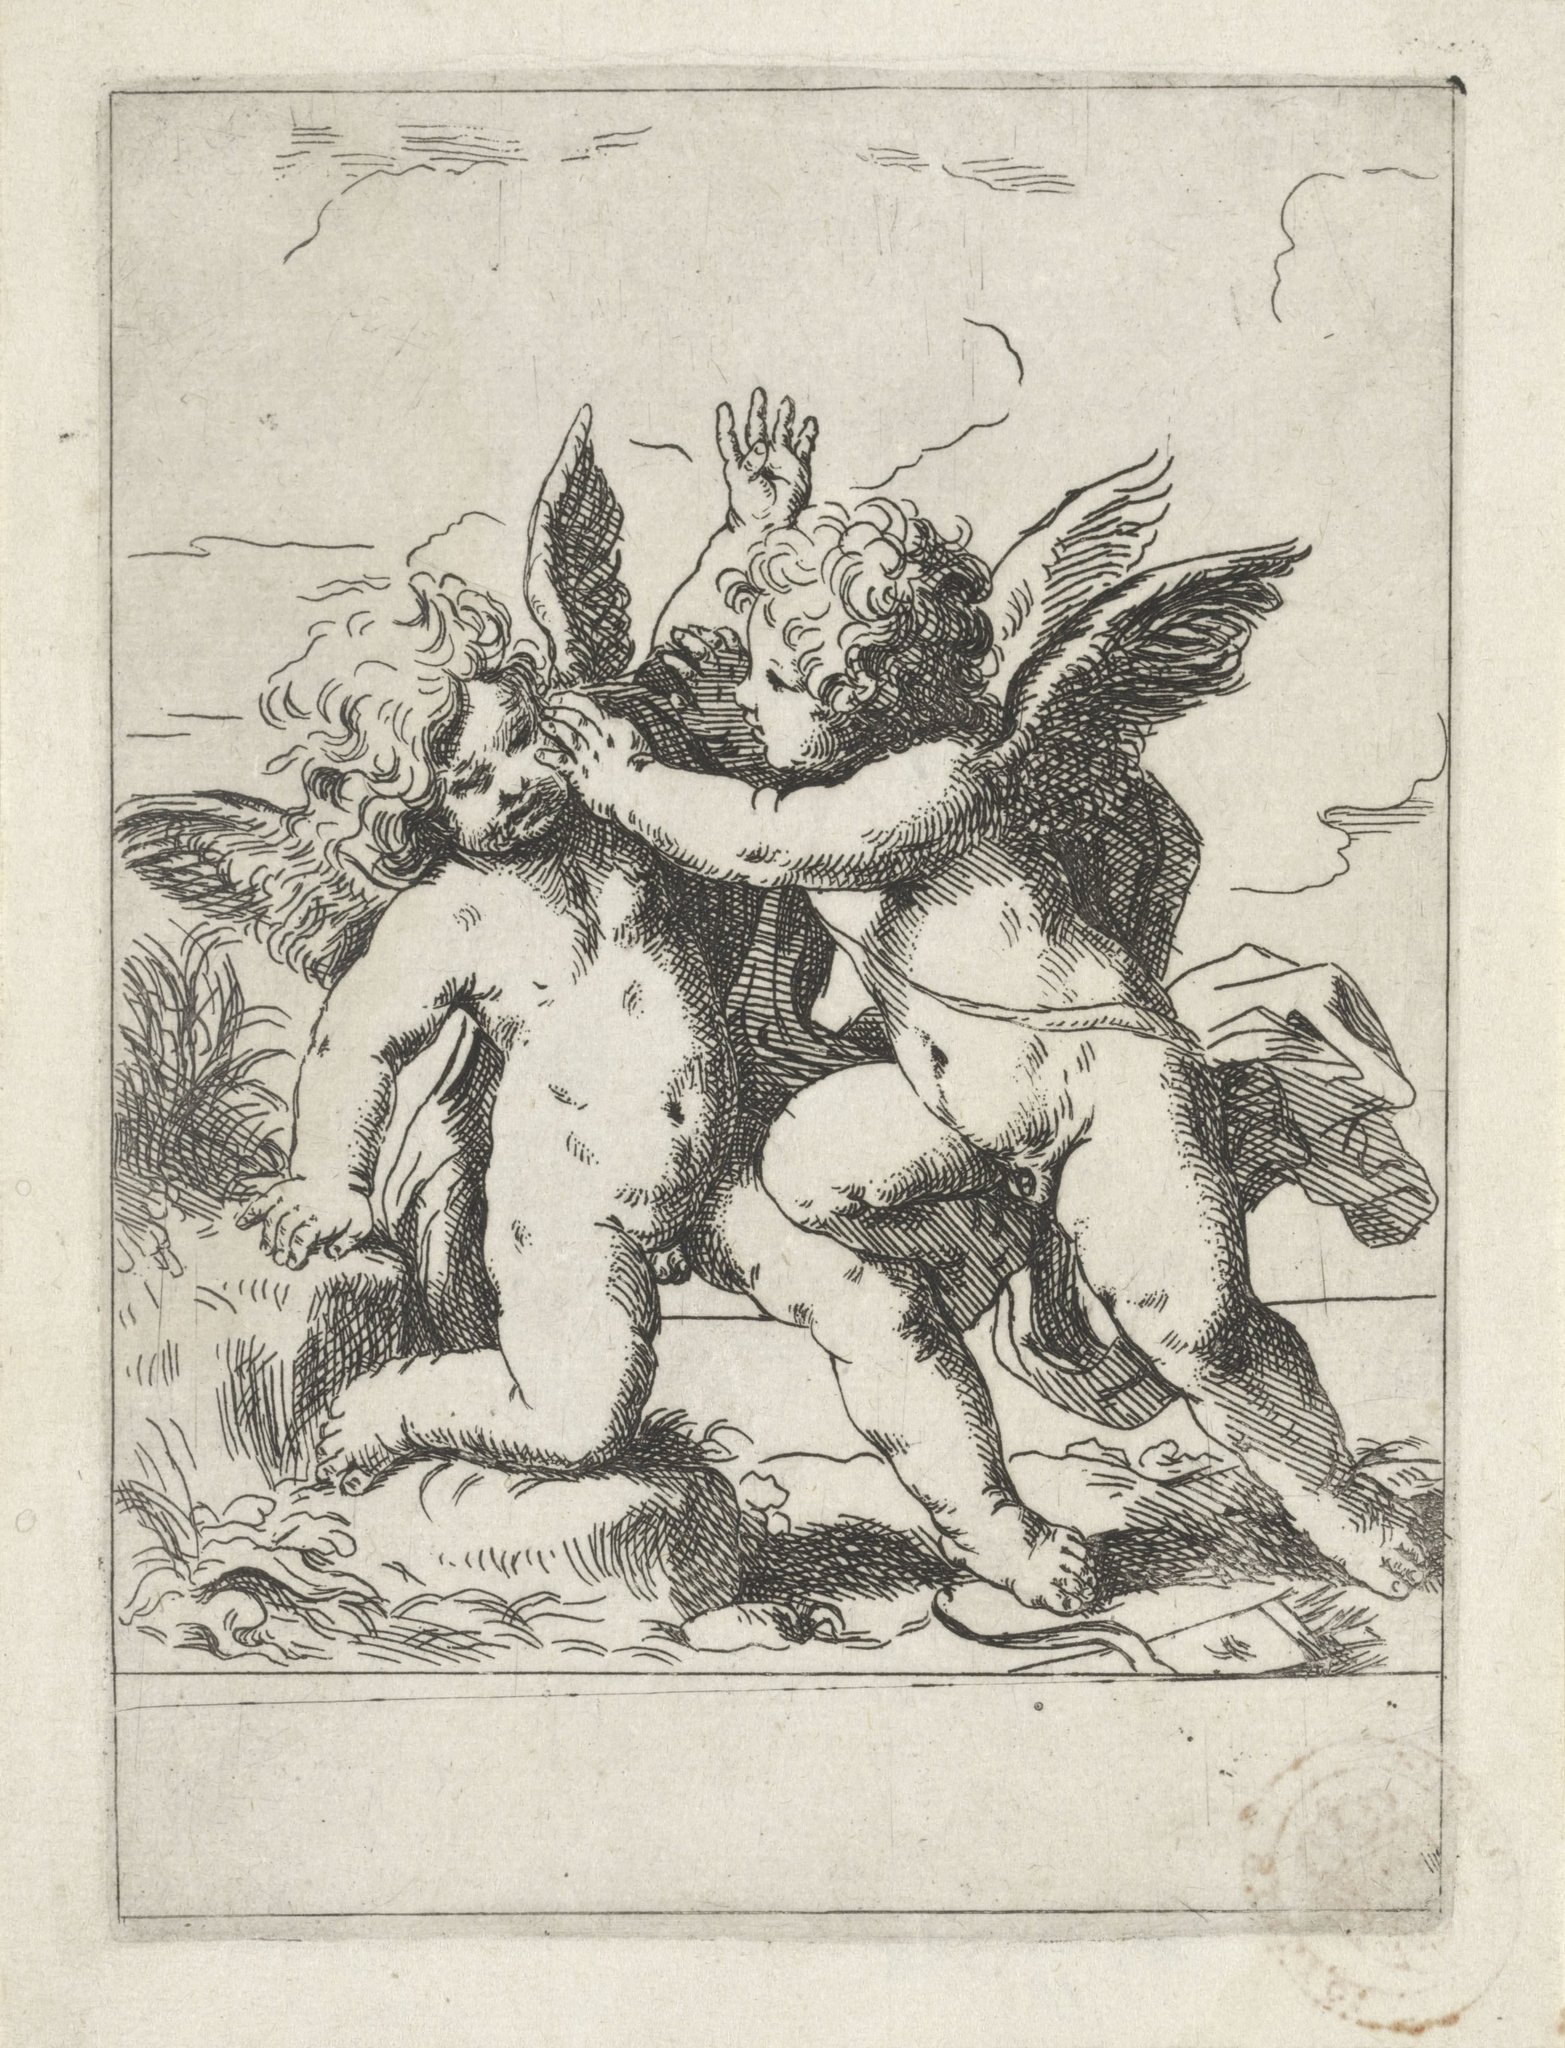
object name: print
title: Twee vechtende putti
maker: lorenzo loli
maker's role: print maker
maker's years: 1612-1691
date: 1622-1691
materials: paper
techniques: etching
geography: italy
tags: cupids: 'amores', 'amoretti', 'putti', fighting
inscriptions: collector's mark: Lugt 240